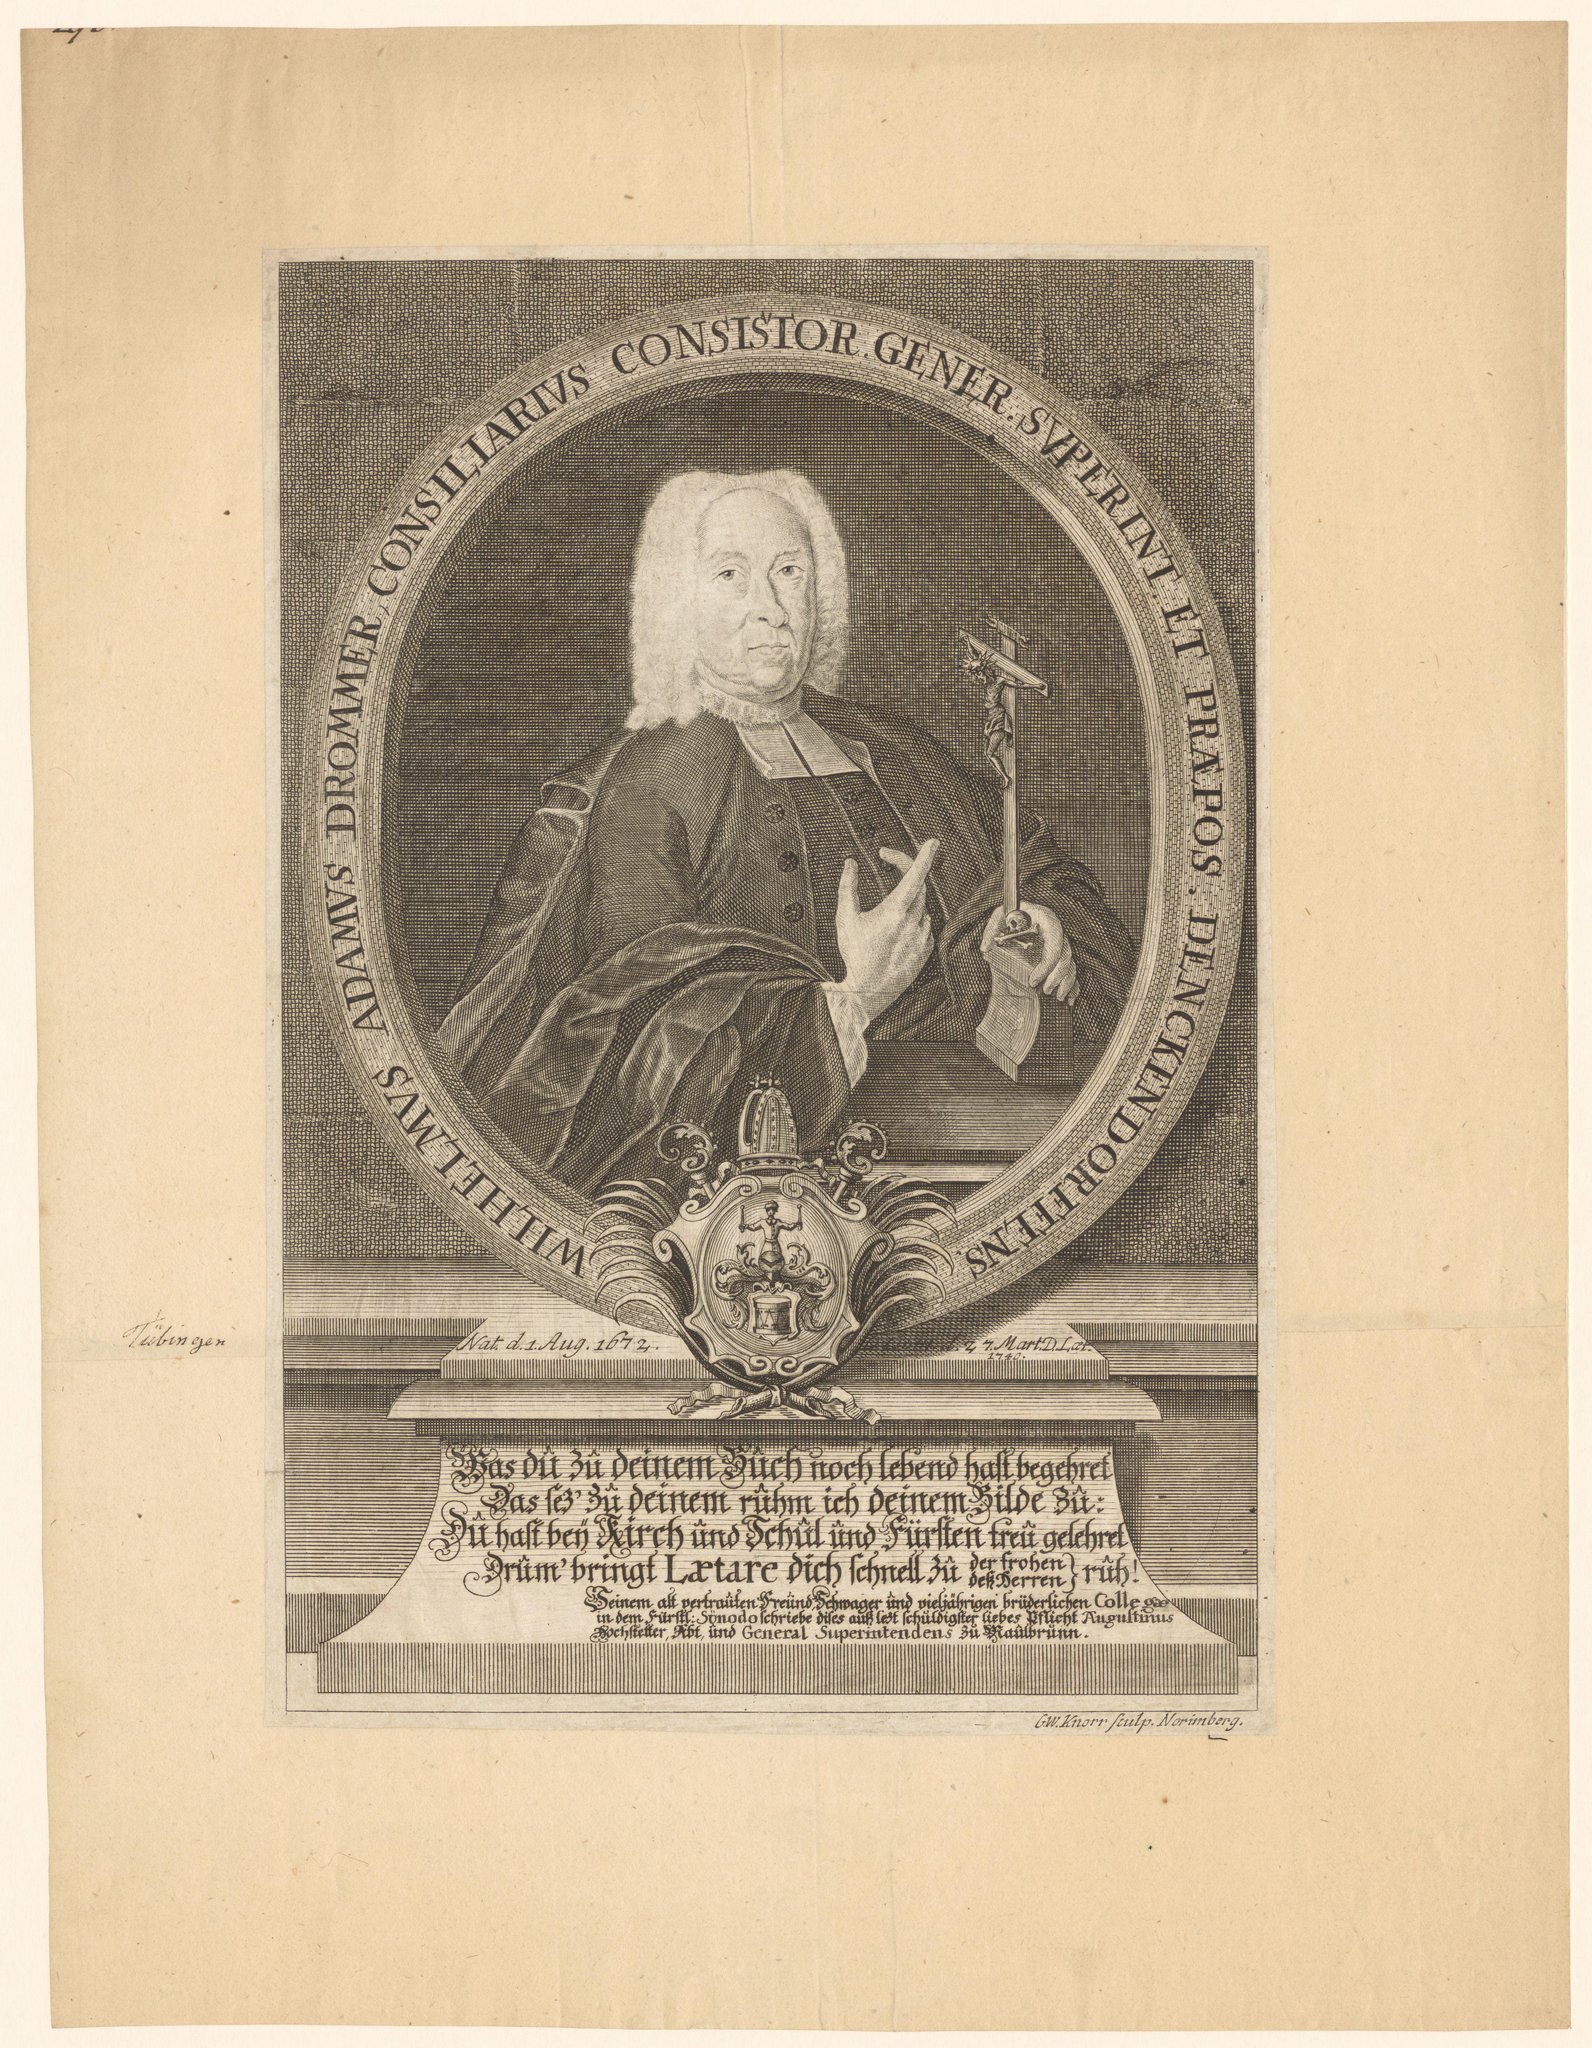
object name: print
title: Portret van Wilhelm Adam Drommer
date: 1715-1748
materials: paper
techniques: engraving, etching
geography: nuremberg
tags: theologian, historical persons, crucifix ~ personal devotion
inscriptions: collector's mark: Lugt 2228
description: Tekst in het Latijn in de omlijsting en tekst in het Duits in de ondermarge.